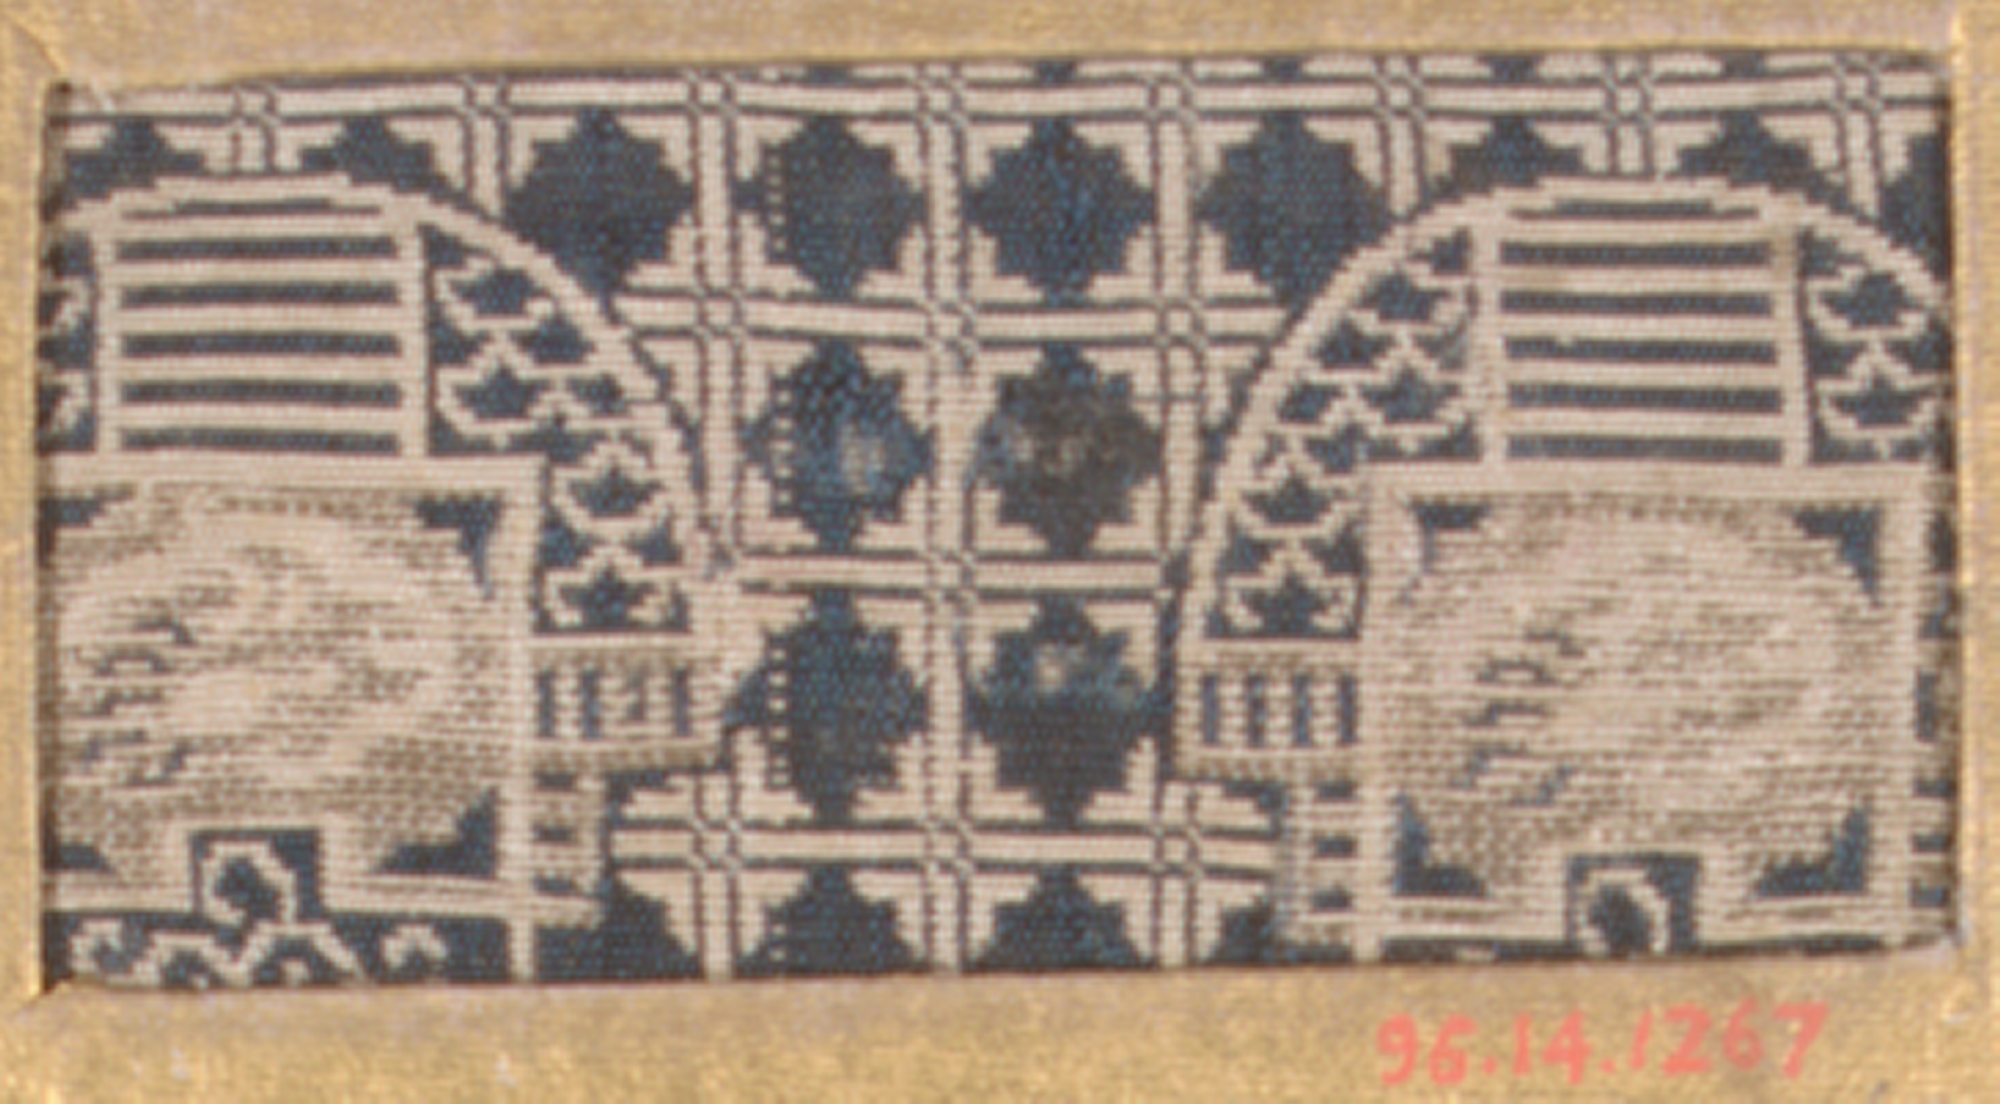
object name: piece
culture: japanese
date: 1701-1900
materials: silk